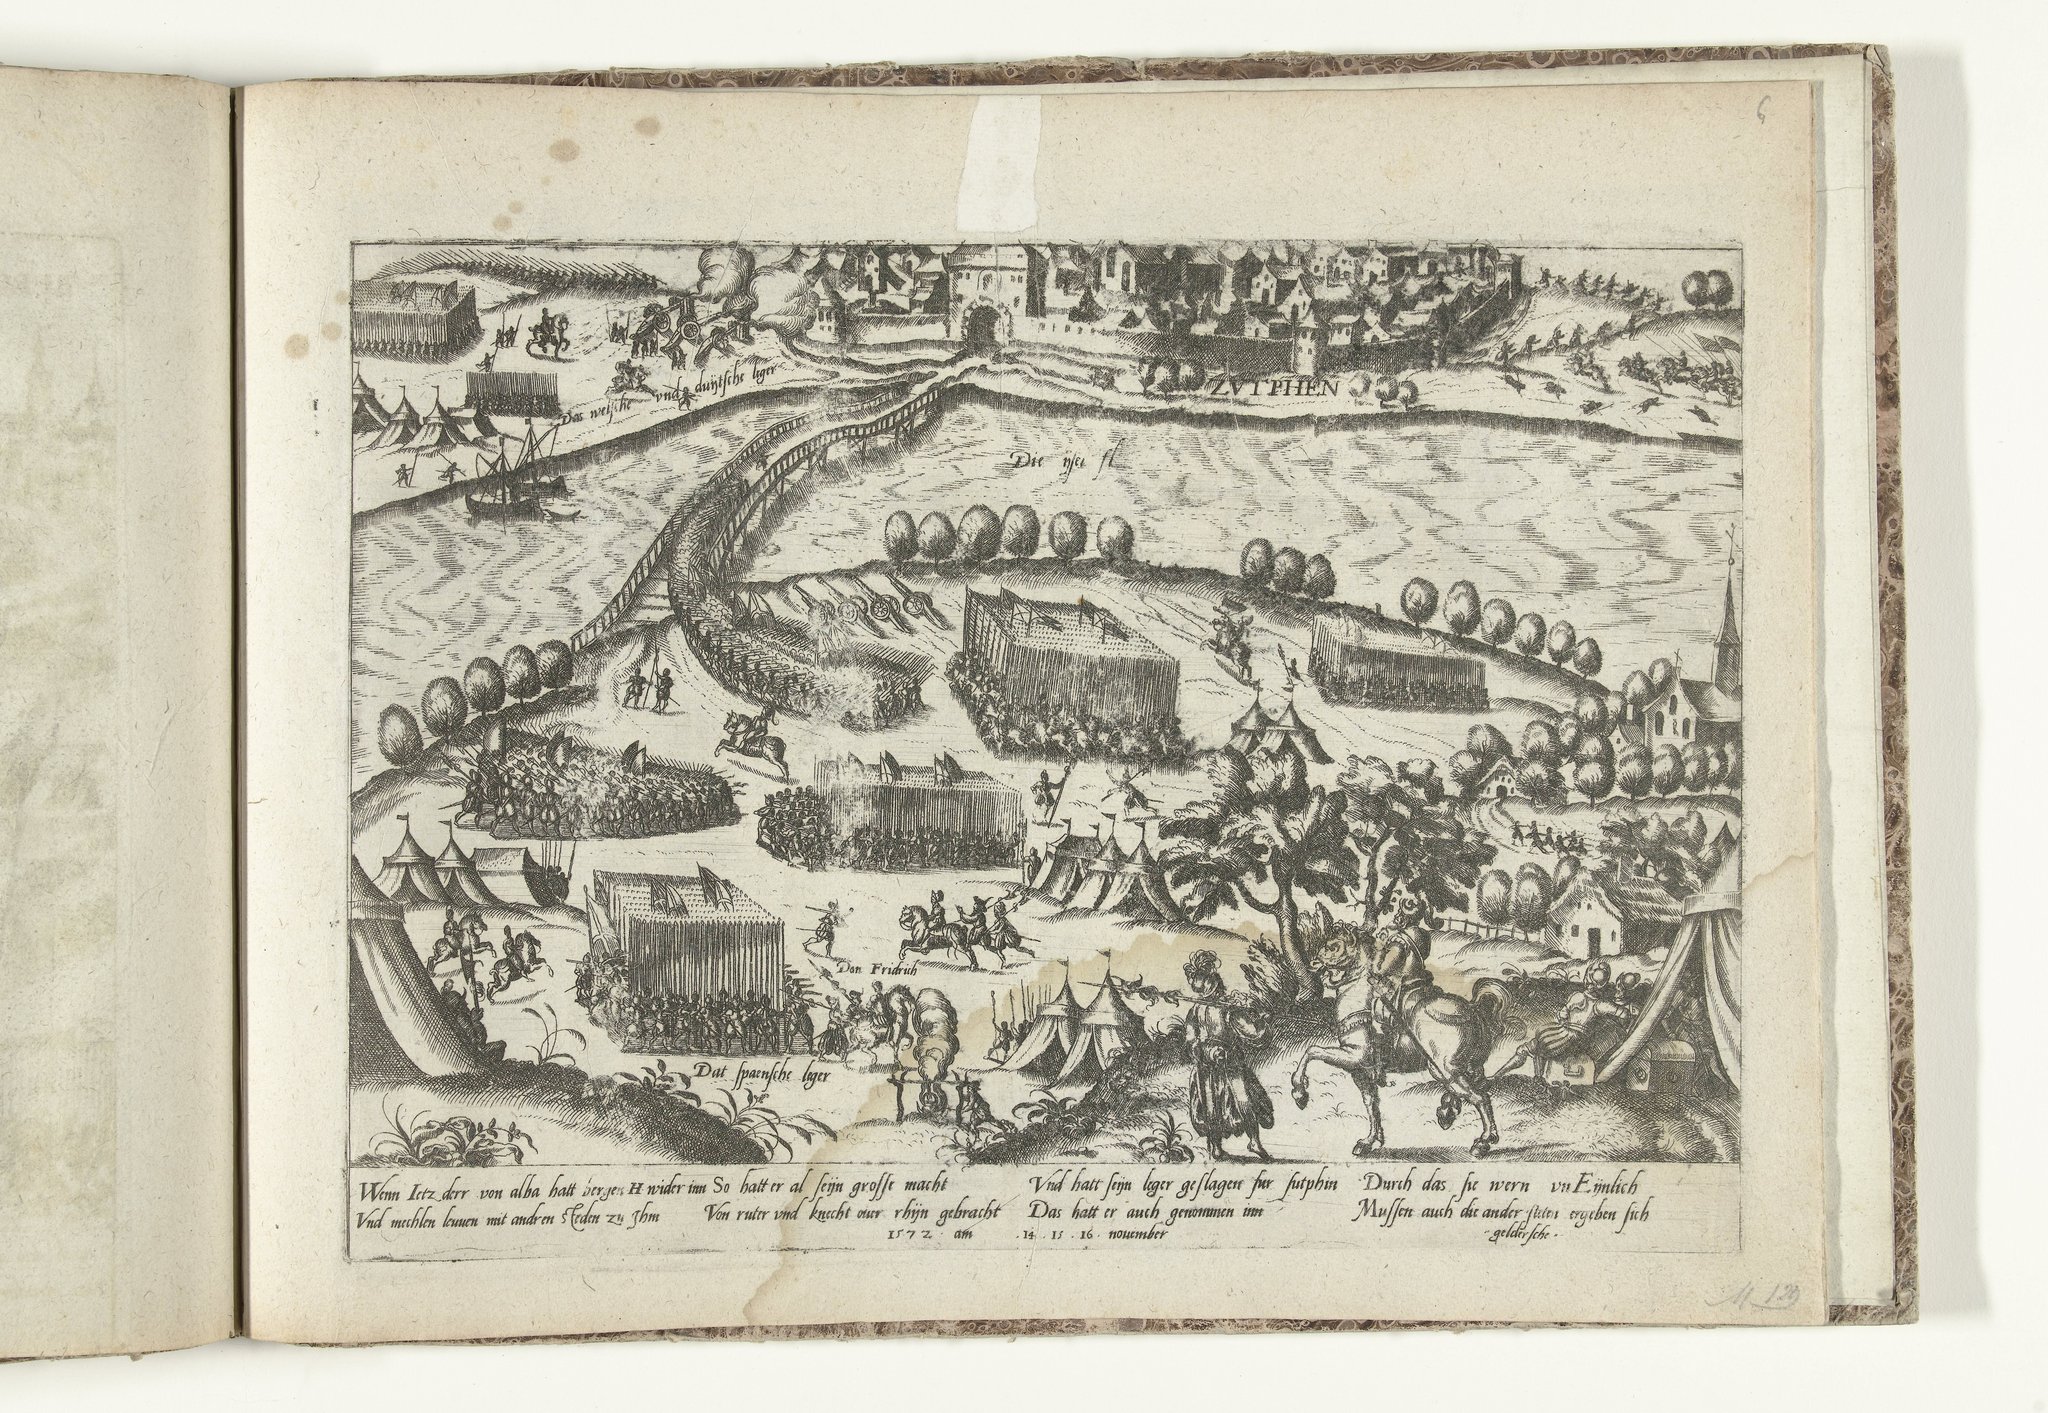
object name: print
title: Serie 6: Nederlandse Gebeurtenissen, 1571-1576 (kopieën)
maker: Anonymous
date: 1572-1574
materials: paper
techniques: etching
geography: germany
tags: capture of city (after the siege)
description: Beschieting en bestorming van Zutphen door de Spaanse troepen onder Don Frederik, 16 november 1572. Gezicht vanuit het legerkamp, op de voorgrond Don Frederik te paard, in de vere de belegerde stad. Met onderschrift van 2 regels in het Duits en de datum. Ongenummerd. De prent maakt deel uit van een album.